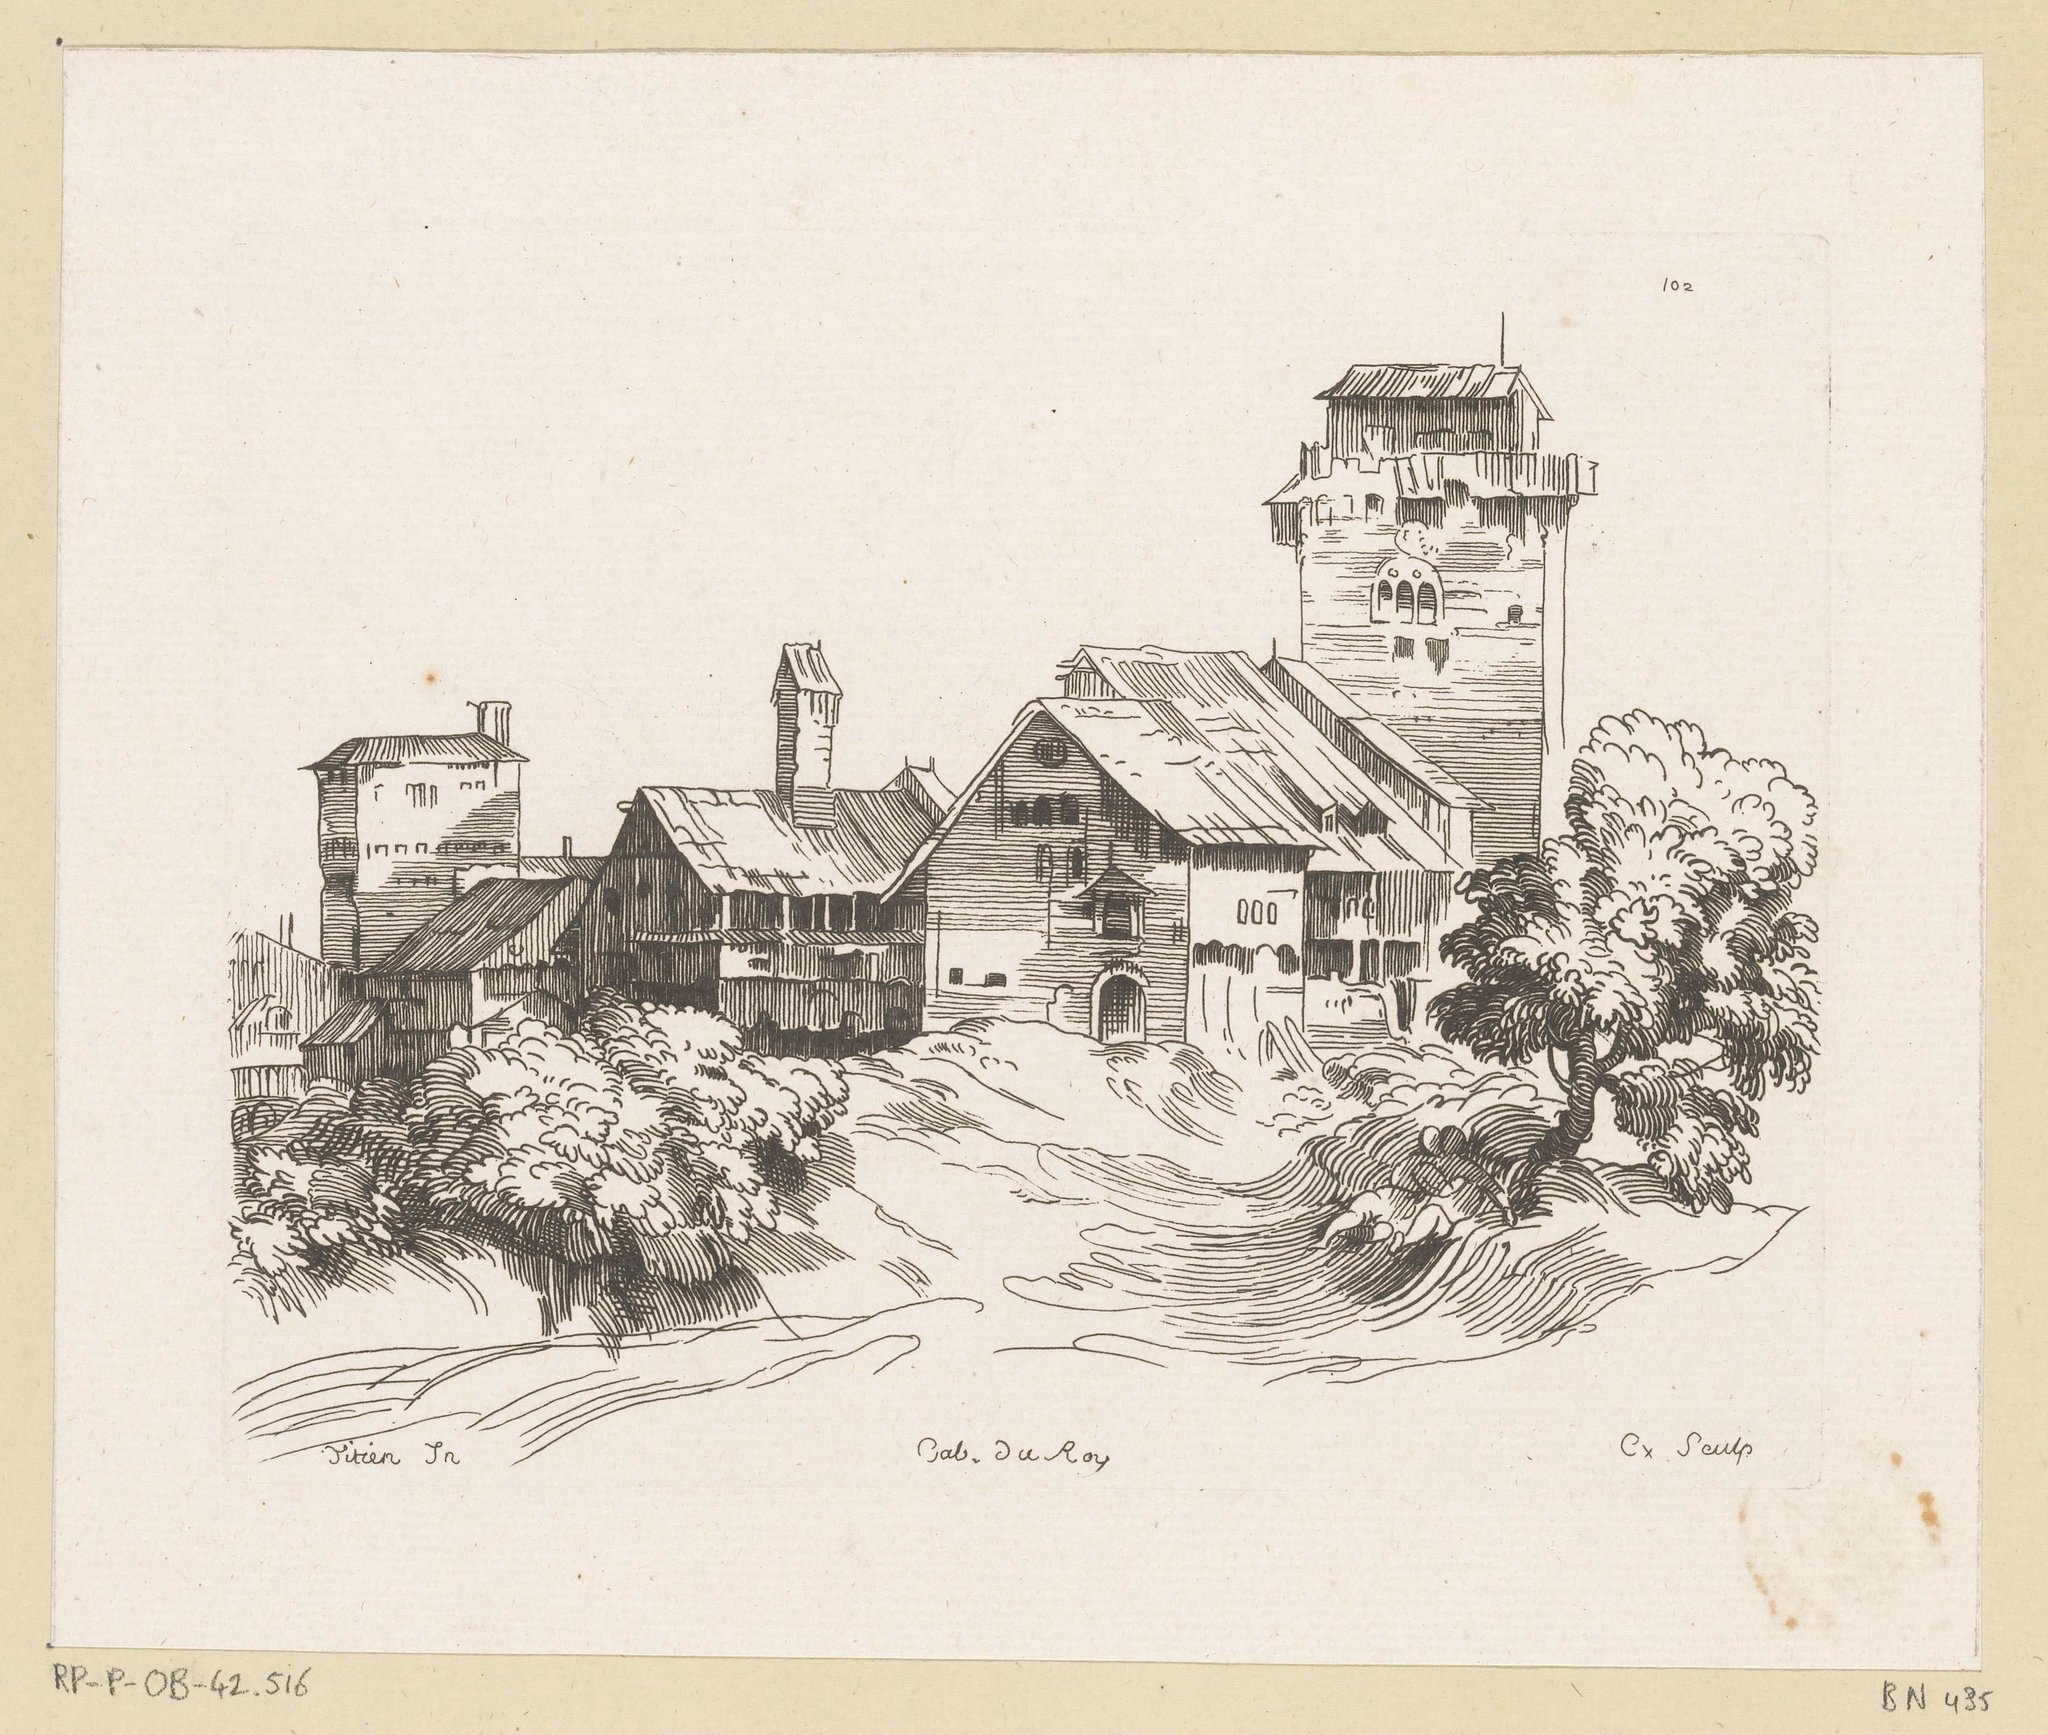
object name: print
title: Dorp in een landschap met rechts een toren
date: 1702-1765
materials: paper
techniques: etching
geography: france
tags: village, tower (of house or building)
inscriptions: collector's mark: Lugt 240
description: Maakt deel uit van een serie getiteld: "Cabinet du Roy" van 222 etsen naar tekeningen uit de Franse koninklijke collectie.